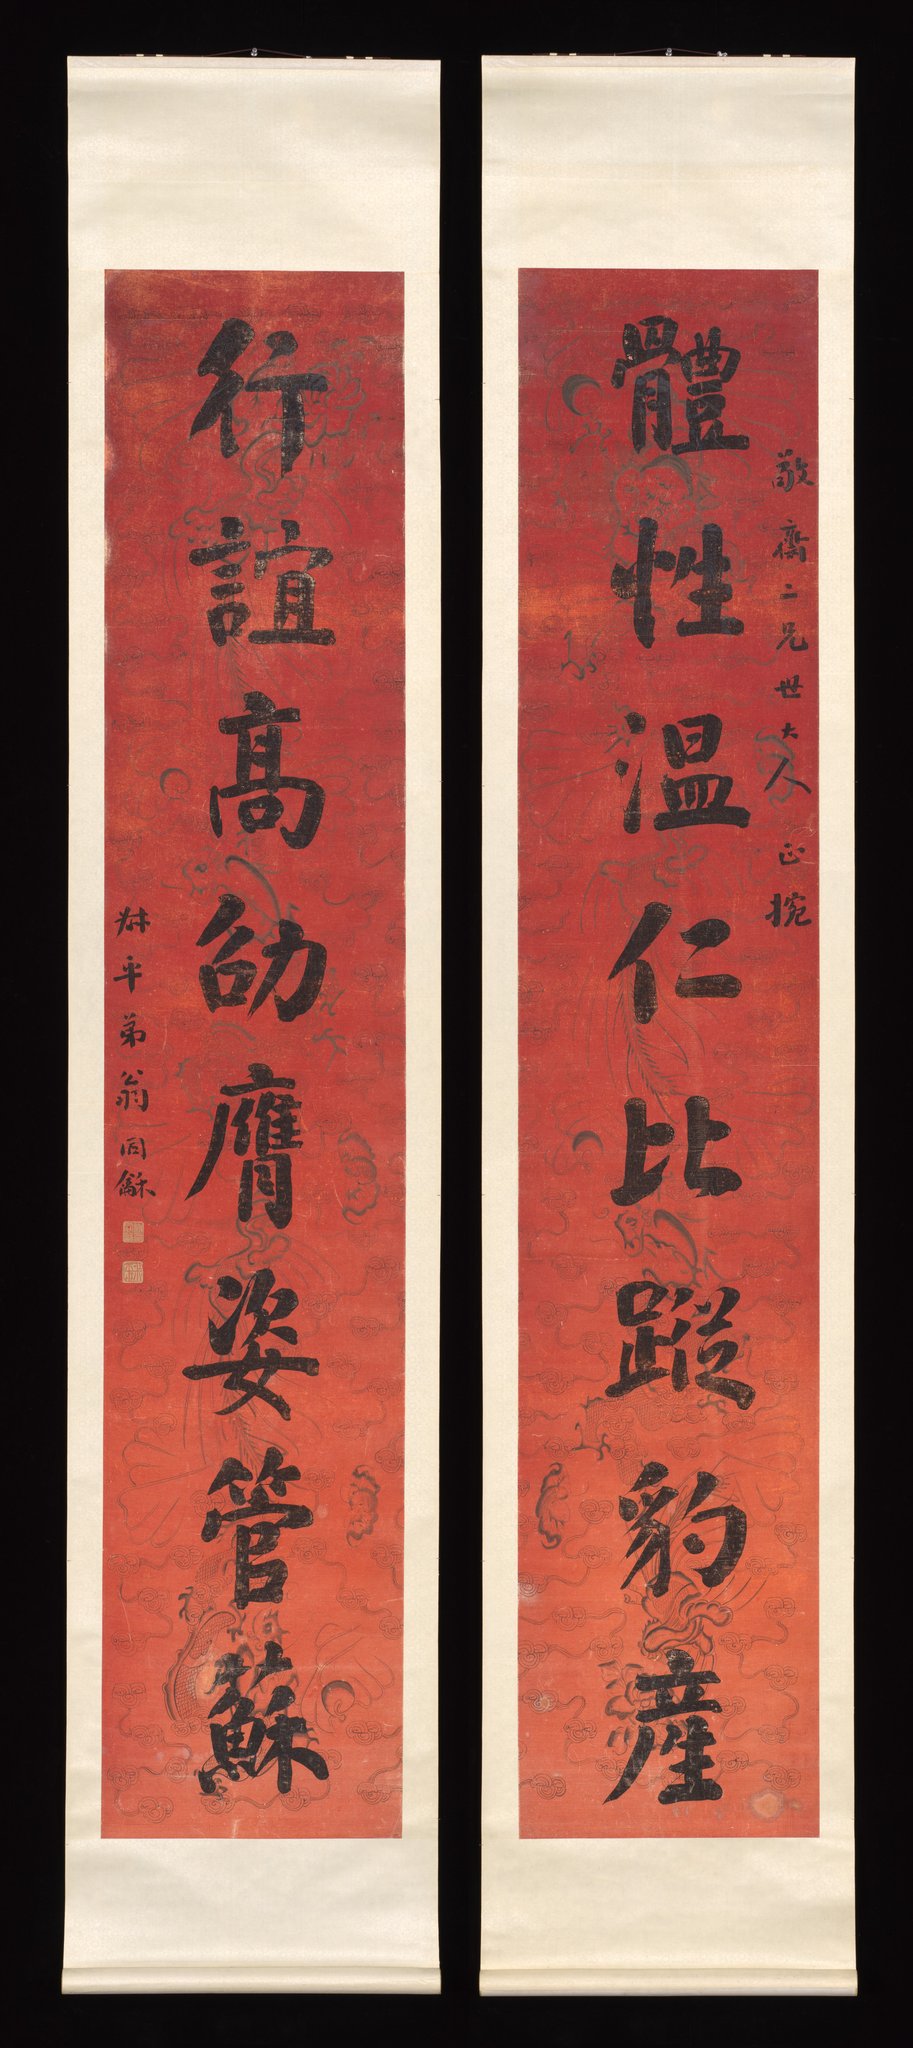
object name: hanging scroll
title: Regular-script Calligraphic Couplet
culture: chinese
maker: weng tonghe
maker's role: artist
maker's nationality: chinese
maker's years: 1830-1904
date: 1830-1904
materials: ink, paper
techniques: printing